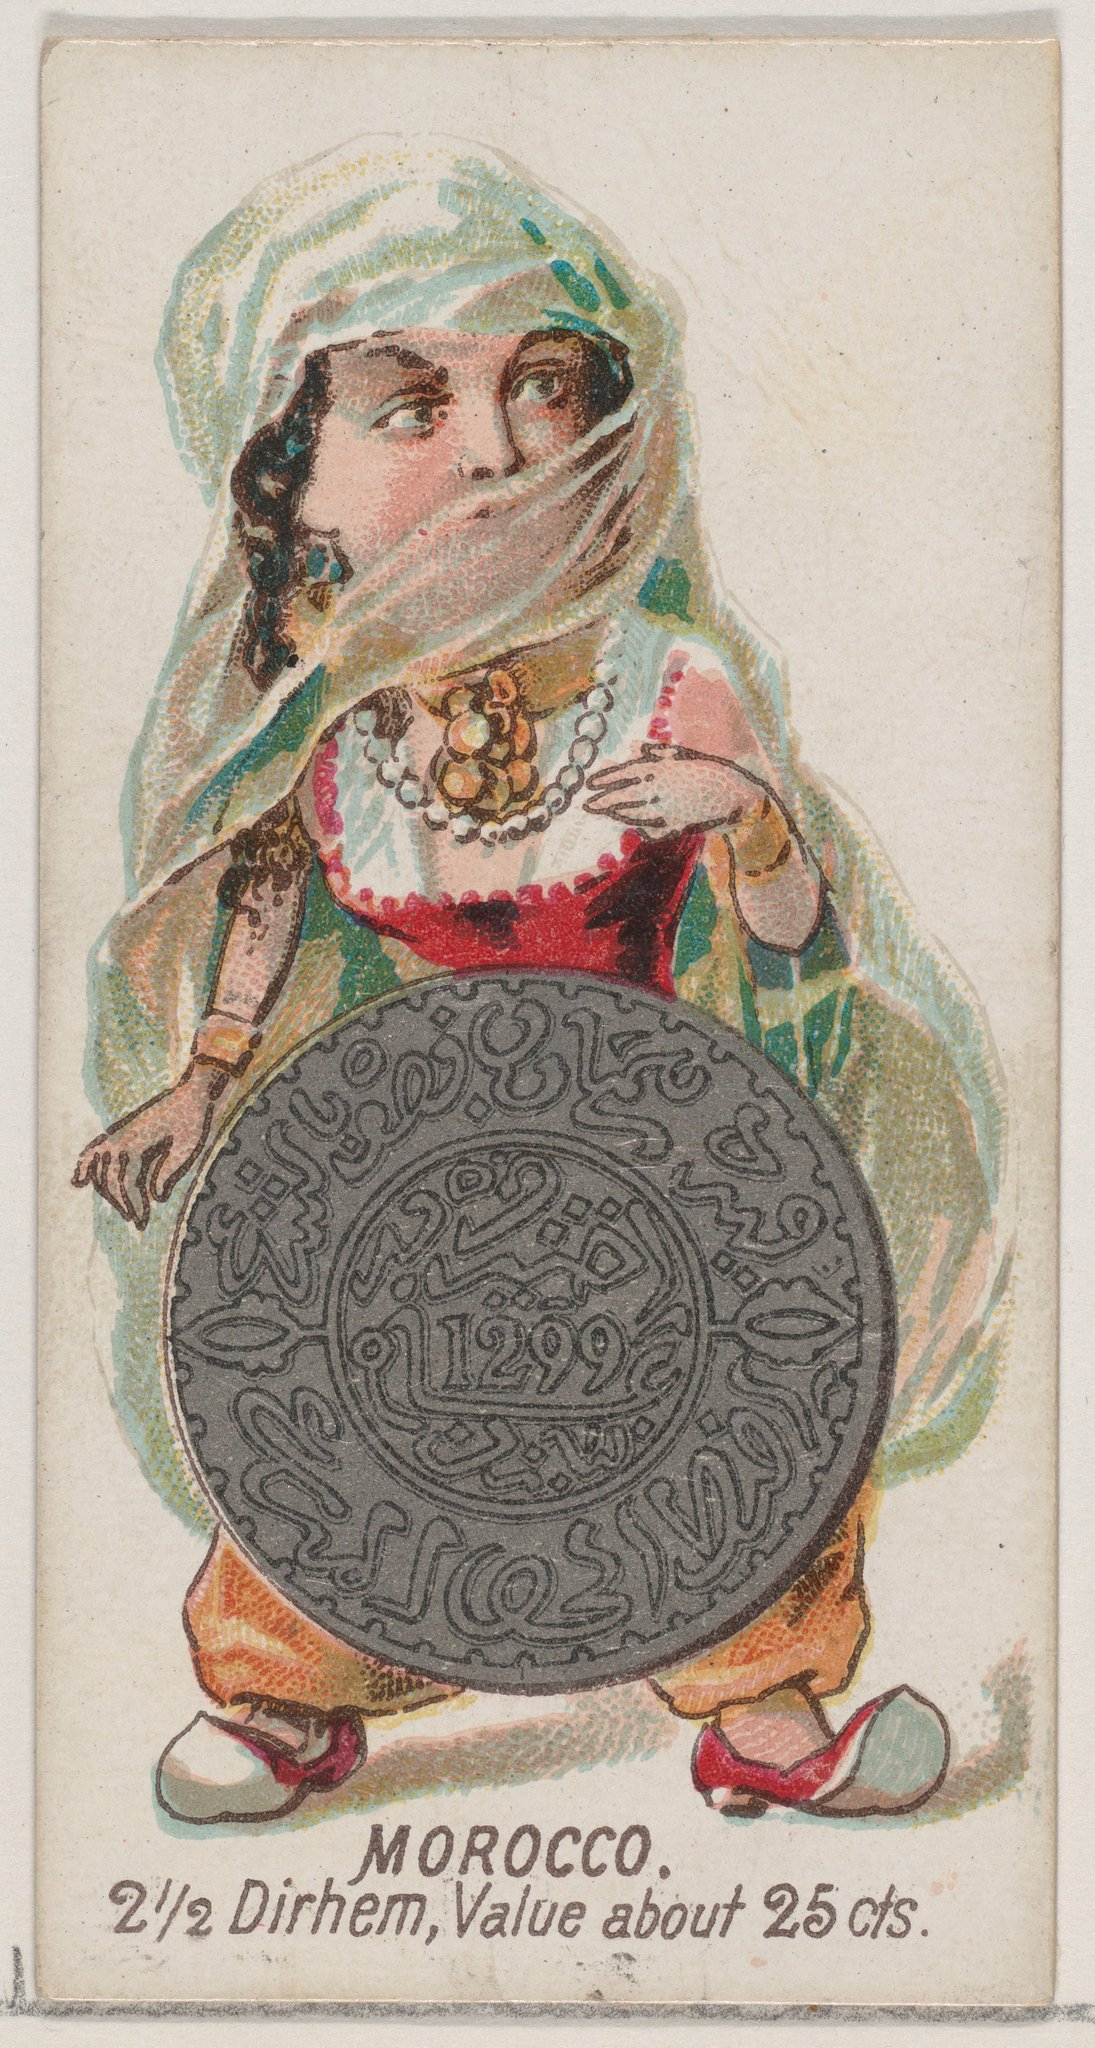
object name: print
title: Morocco, 2 1/2 Dirhem, from the series Coins of All Nations (N72, variation 2) for Duke brand cigarettes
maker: w. duke, sons & co.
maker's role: publisher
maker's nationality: american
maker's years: 1870-1920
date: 1889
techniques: color lithograph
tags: women,coins